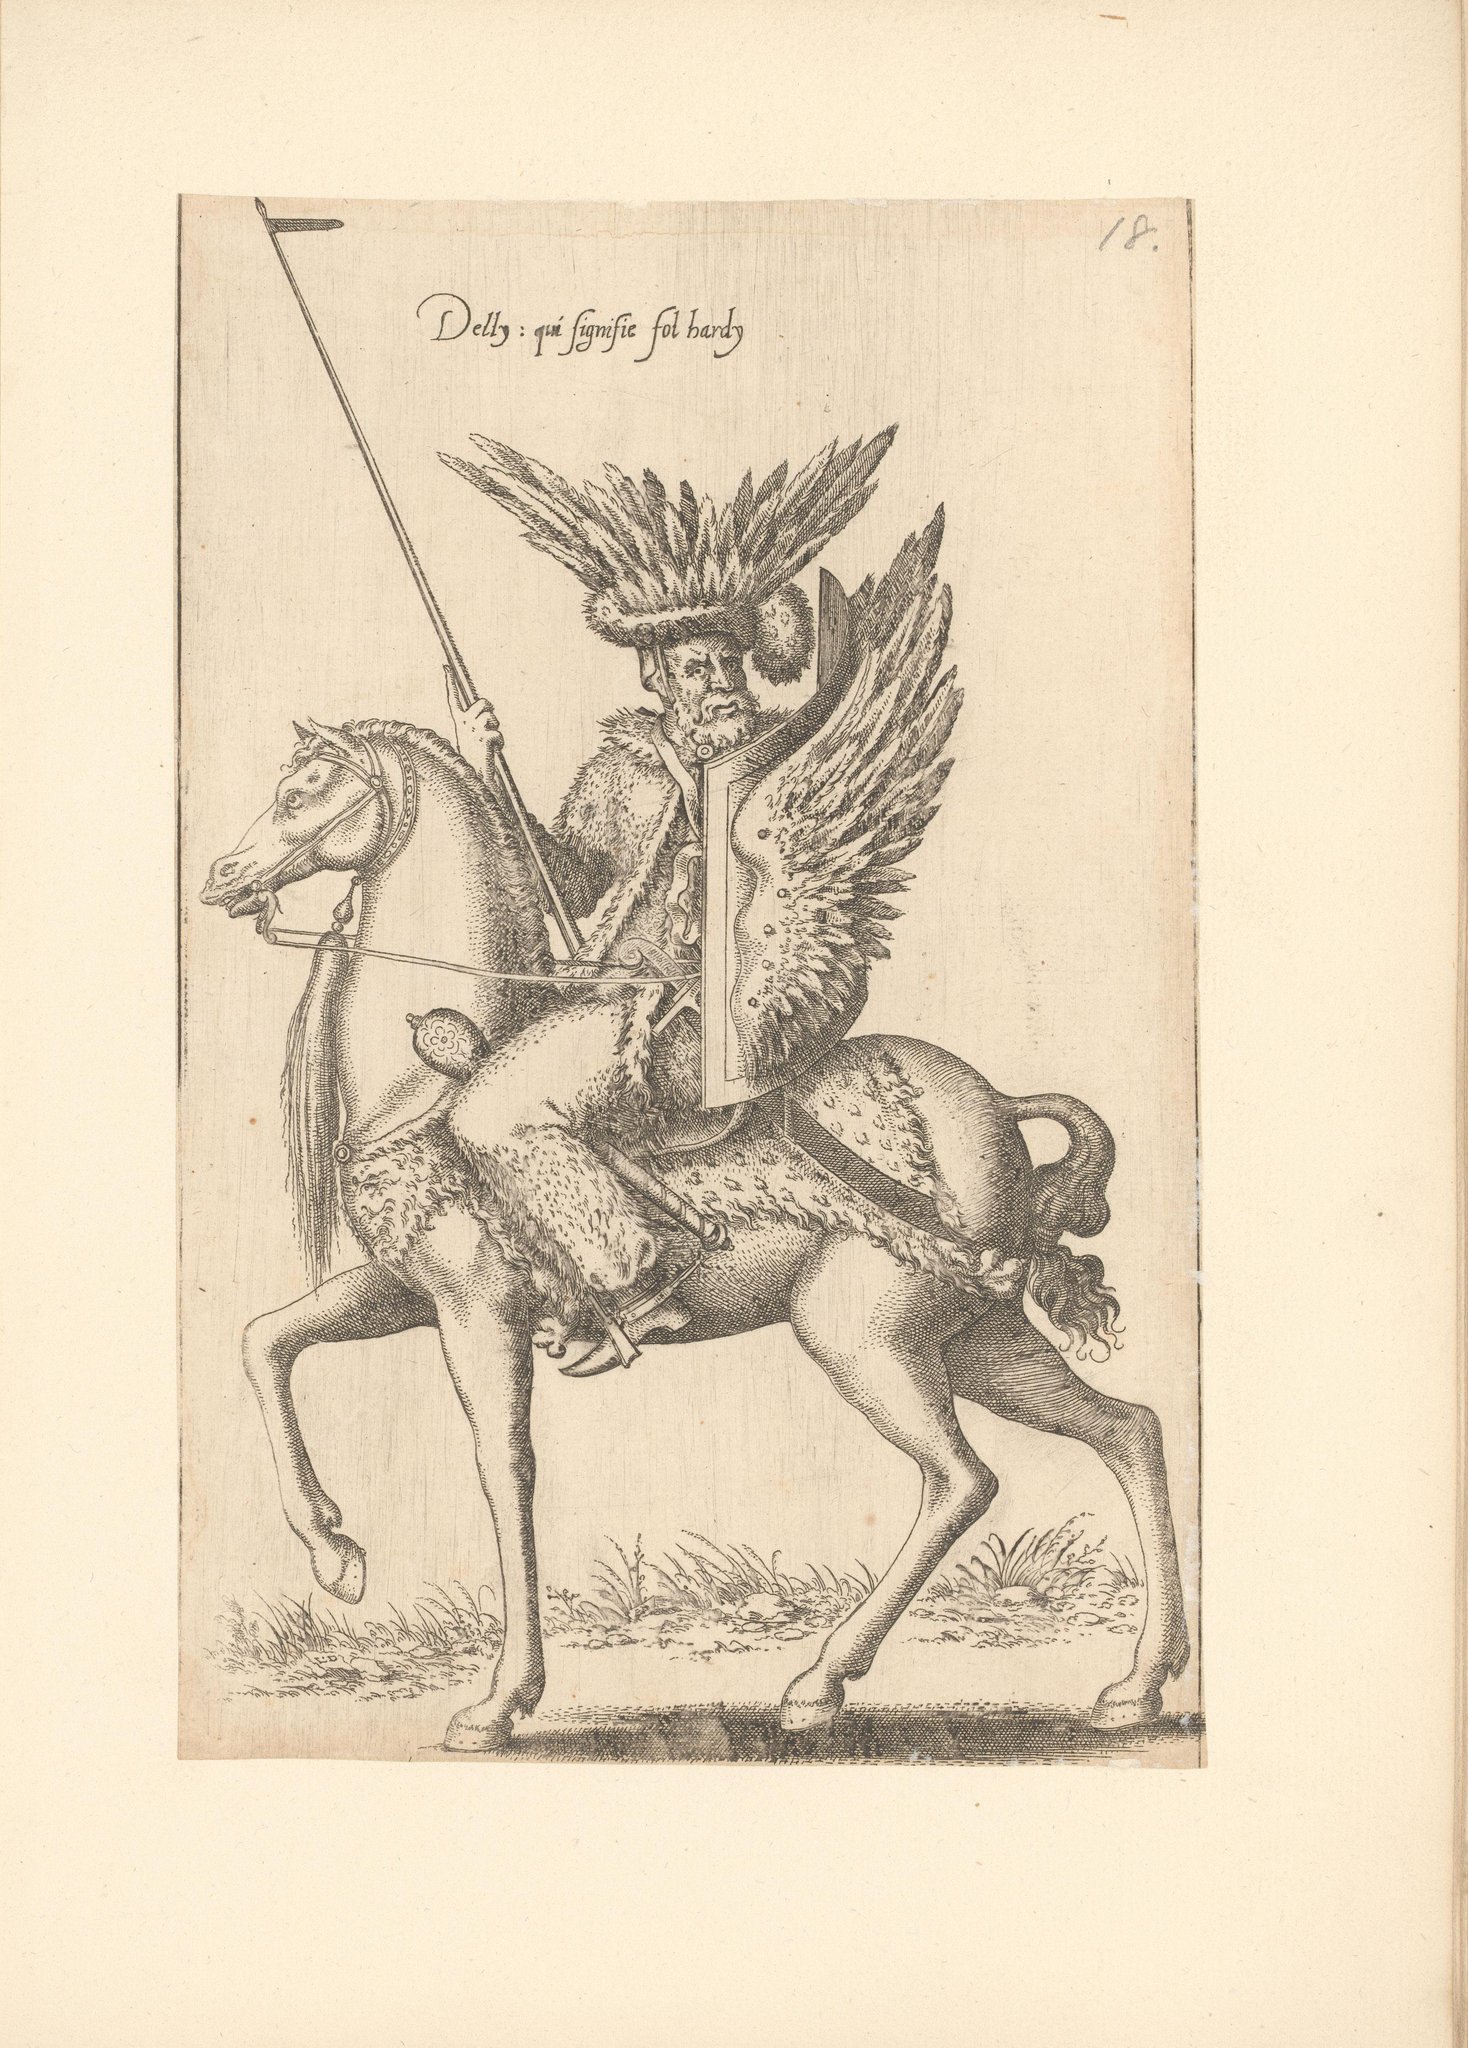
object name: album leaf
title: Delly qui signifie fol hardy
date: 1555-1568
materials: paper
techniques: etching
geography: lyon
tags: riding a horse, ass, or mule; rider, horseman, protective weapons: shield, head-gear: hat (+ feathers used for clothes)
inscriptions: collector's mark: Lugt 2760, collector's mark: Lugt 2228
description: Prent uit: Nicolay, Nicolas de. Les quatre premiers livres des navigations et pérégrinations orientales, de N. de Nicolay, (...) Avec les figures au naturel tant d'hommes que de femmes selon la diversité des nations, & de leur port, maintien & habitz. Lyon: Guillaume (I) Rouille, 1568.